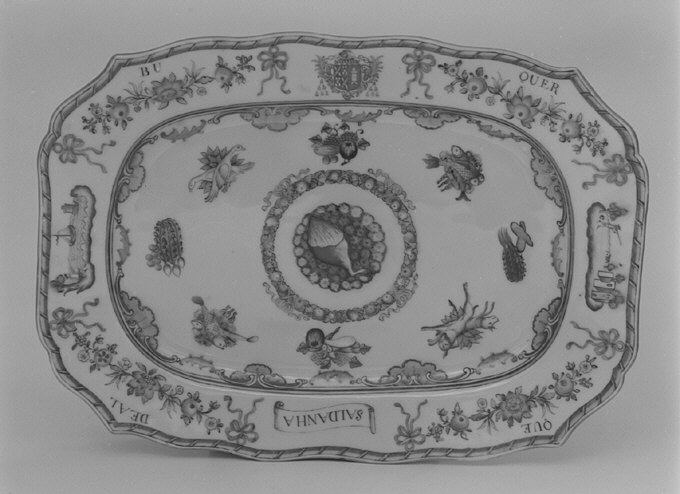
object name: platter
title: Platter (part of a service)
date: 1765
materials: hard paste porcelain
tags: birds,fruit,fish,flowers